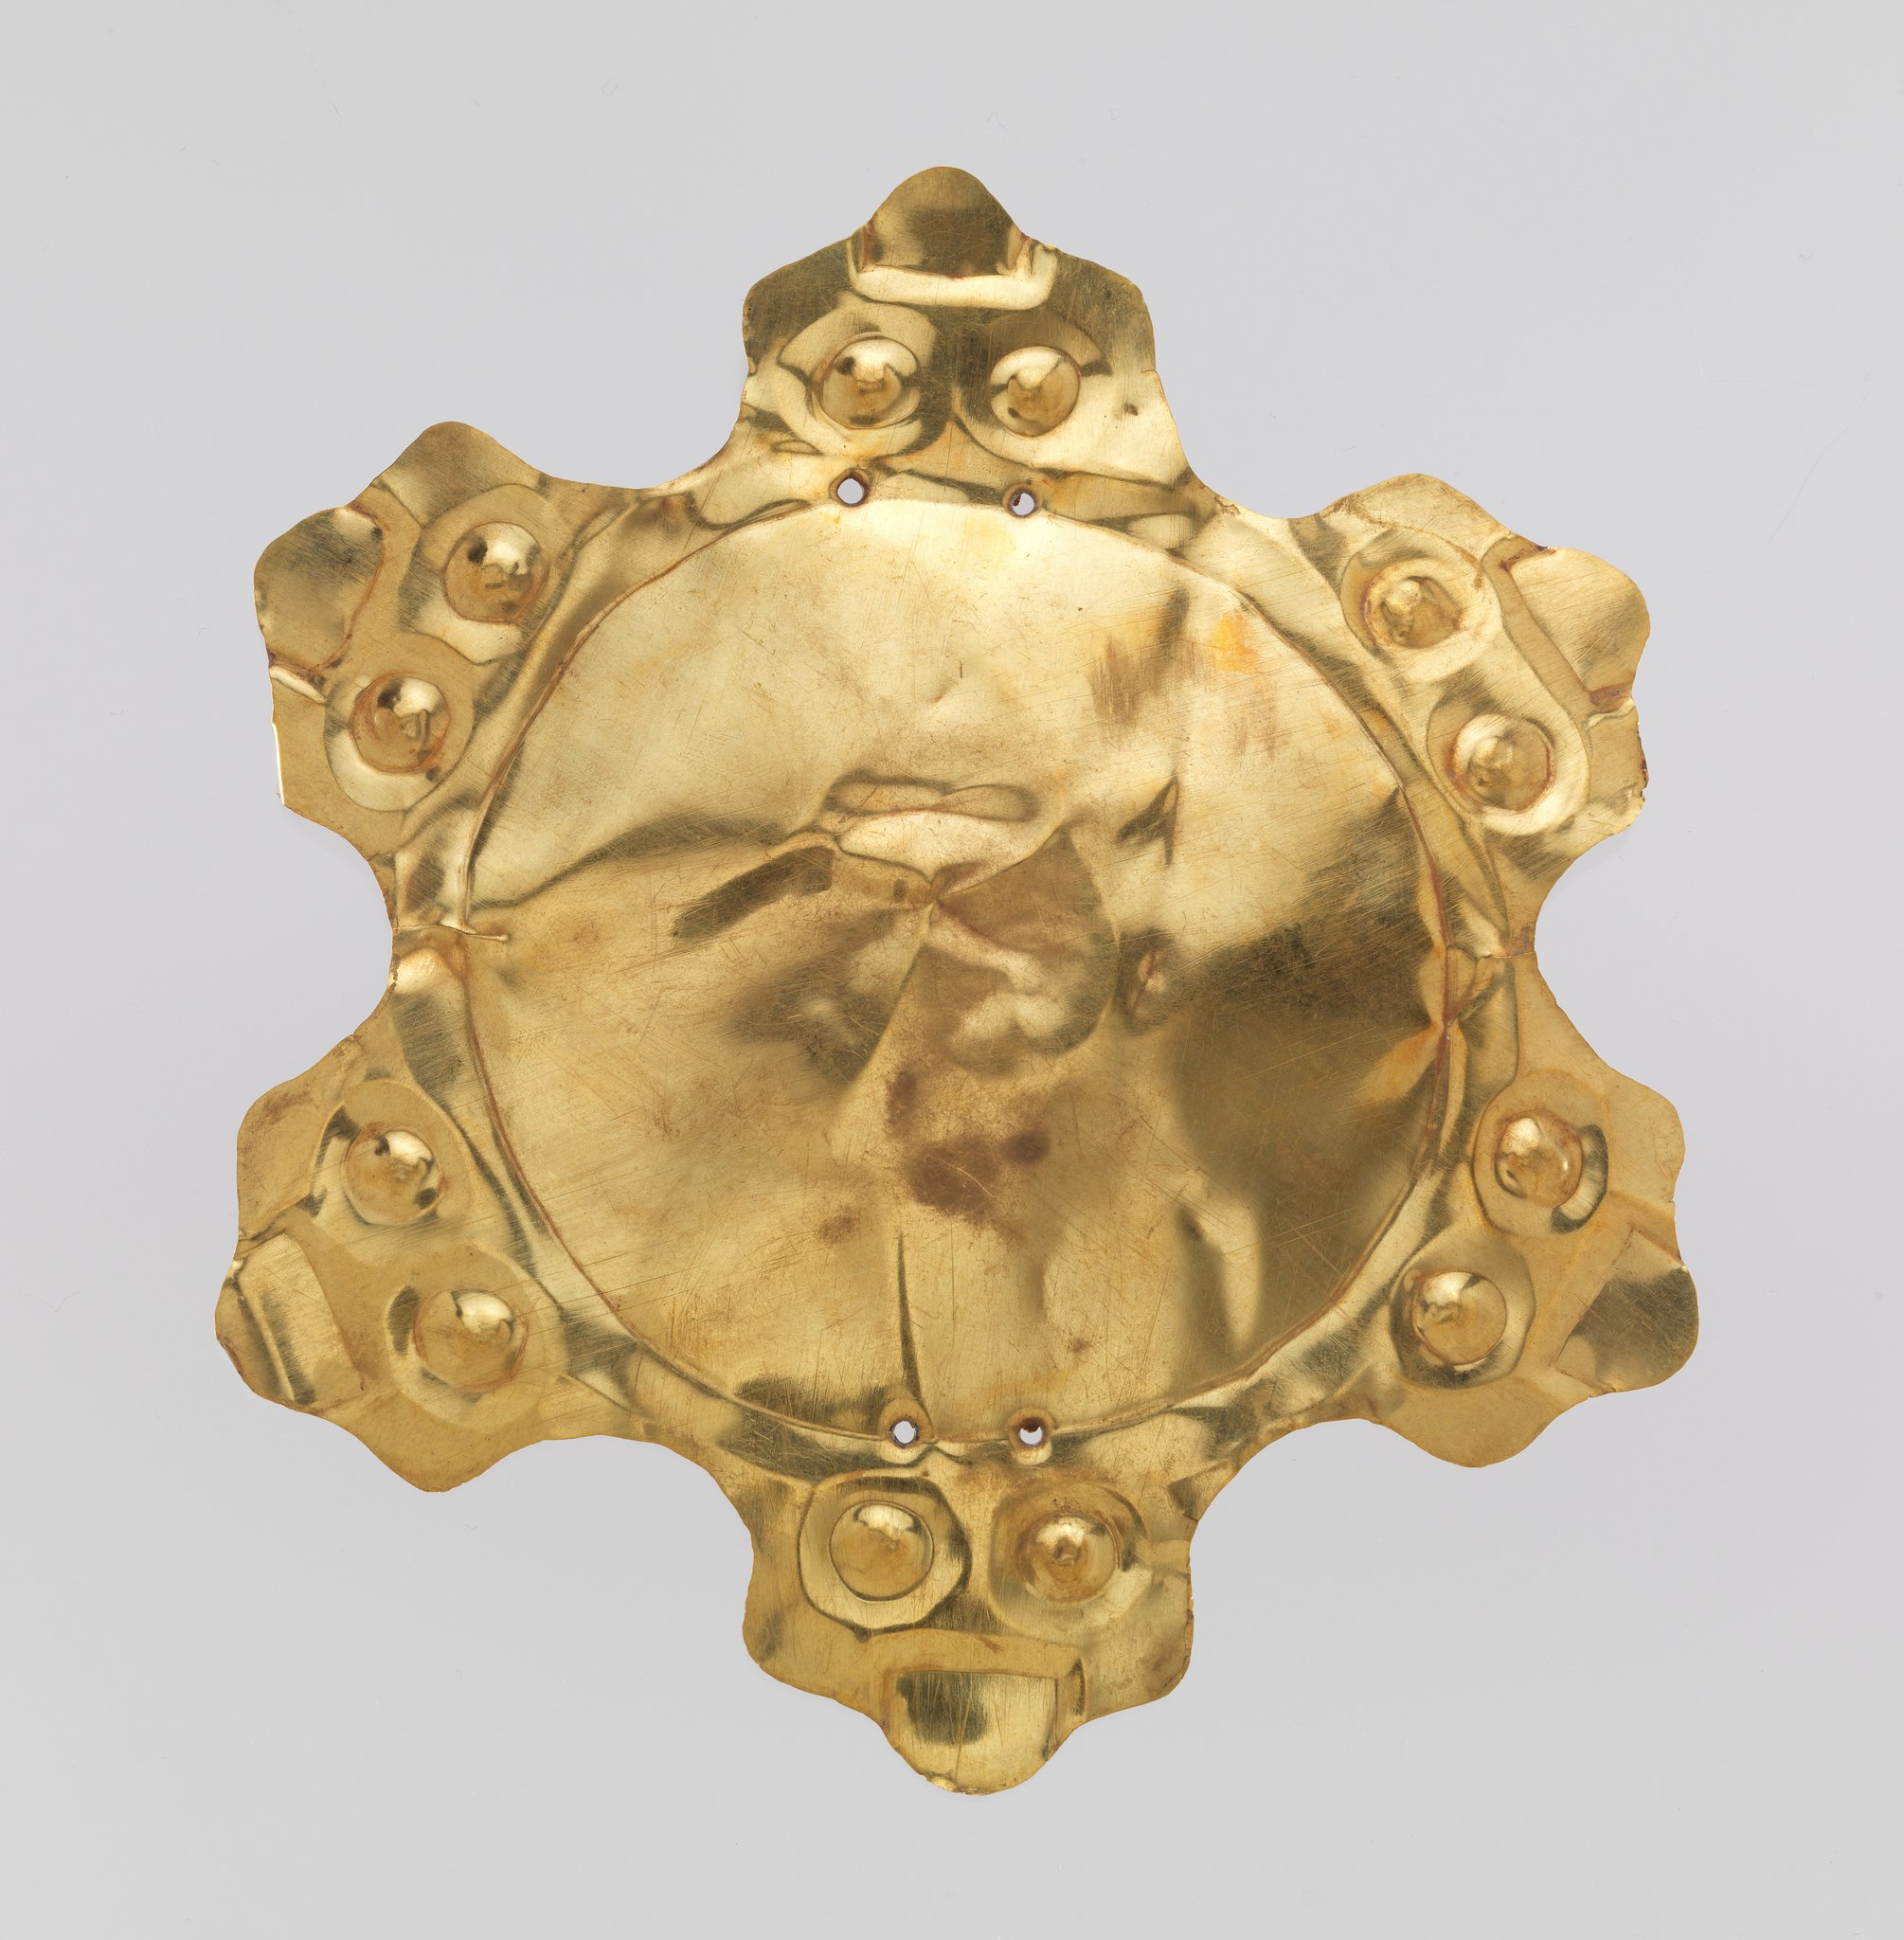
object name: ornament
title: Textile ornament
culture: nasca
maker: nasca artist(s)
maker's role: artist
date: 1-700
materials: gold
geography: peru